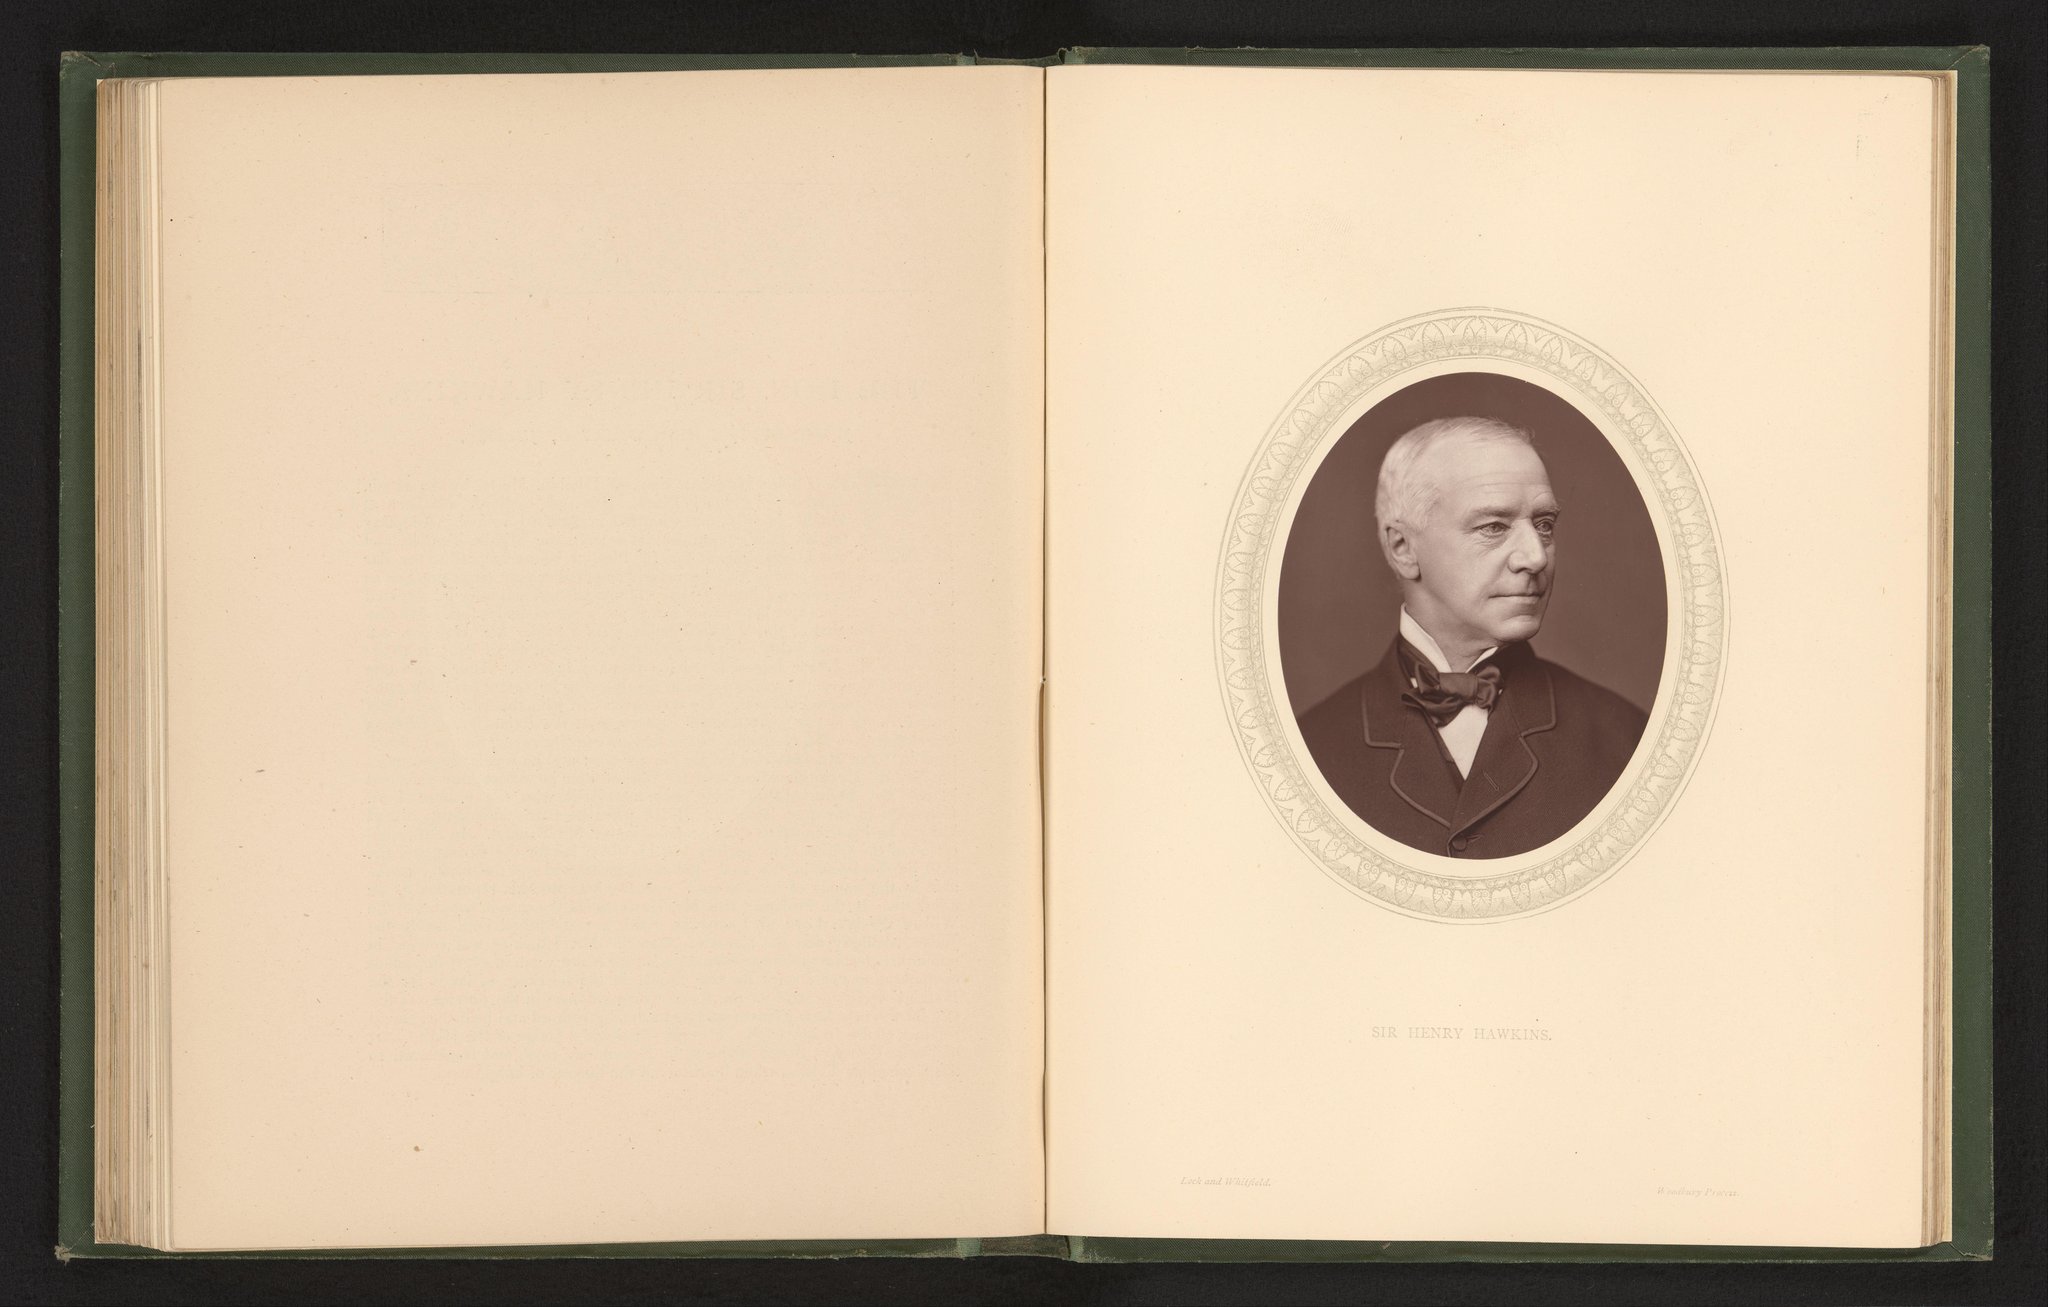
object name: page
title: Sir Henry Hawkins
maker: Anonymous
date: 1872-1877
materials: paper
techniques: woodburytype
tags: historical persons (portraits and scenes from the life) (+ (full) bust portrait), magistracy, judges